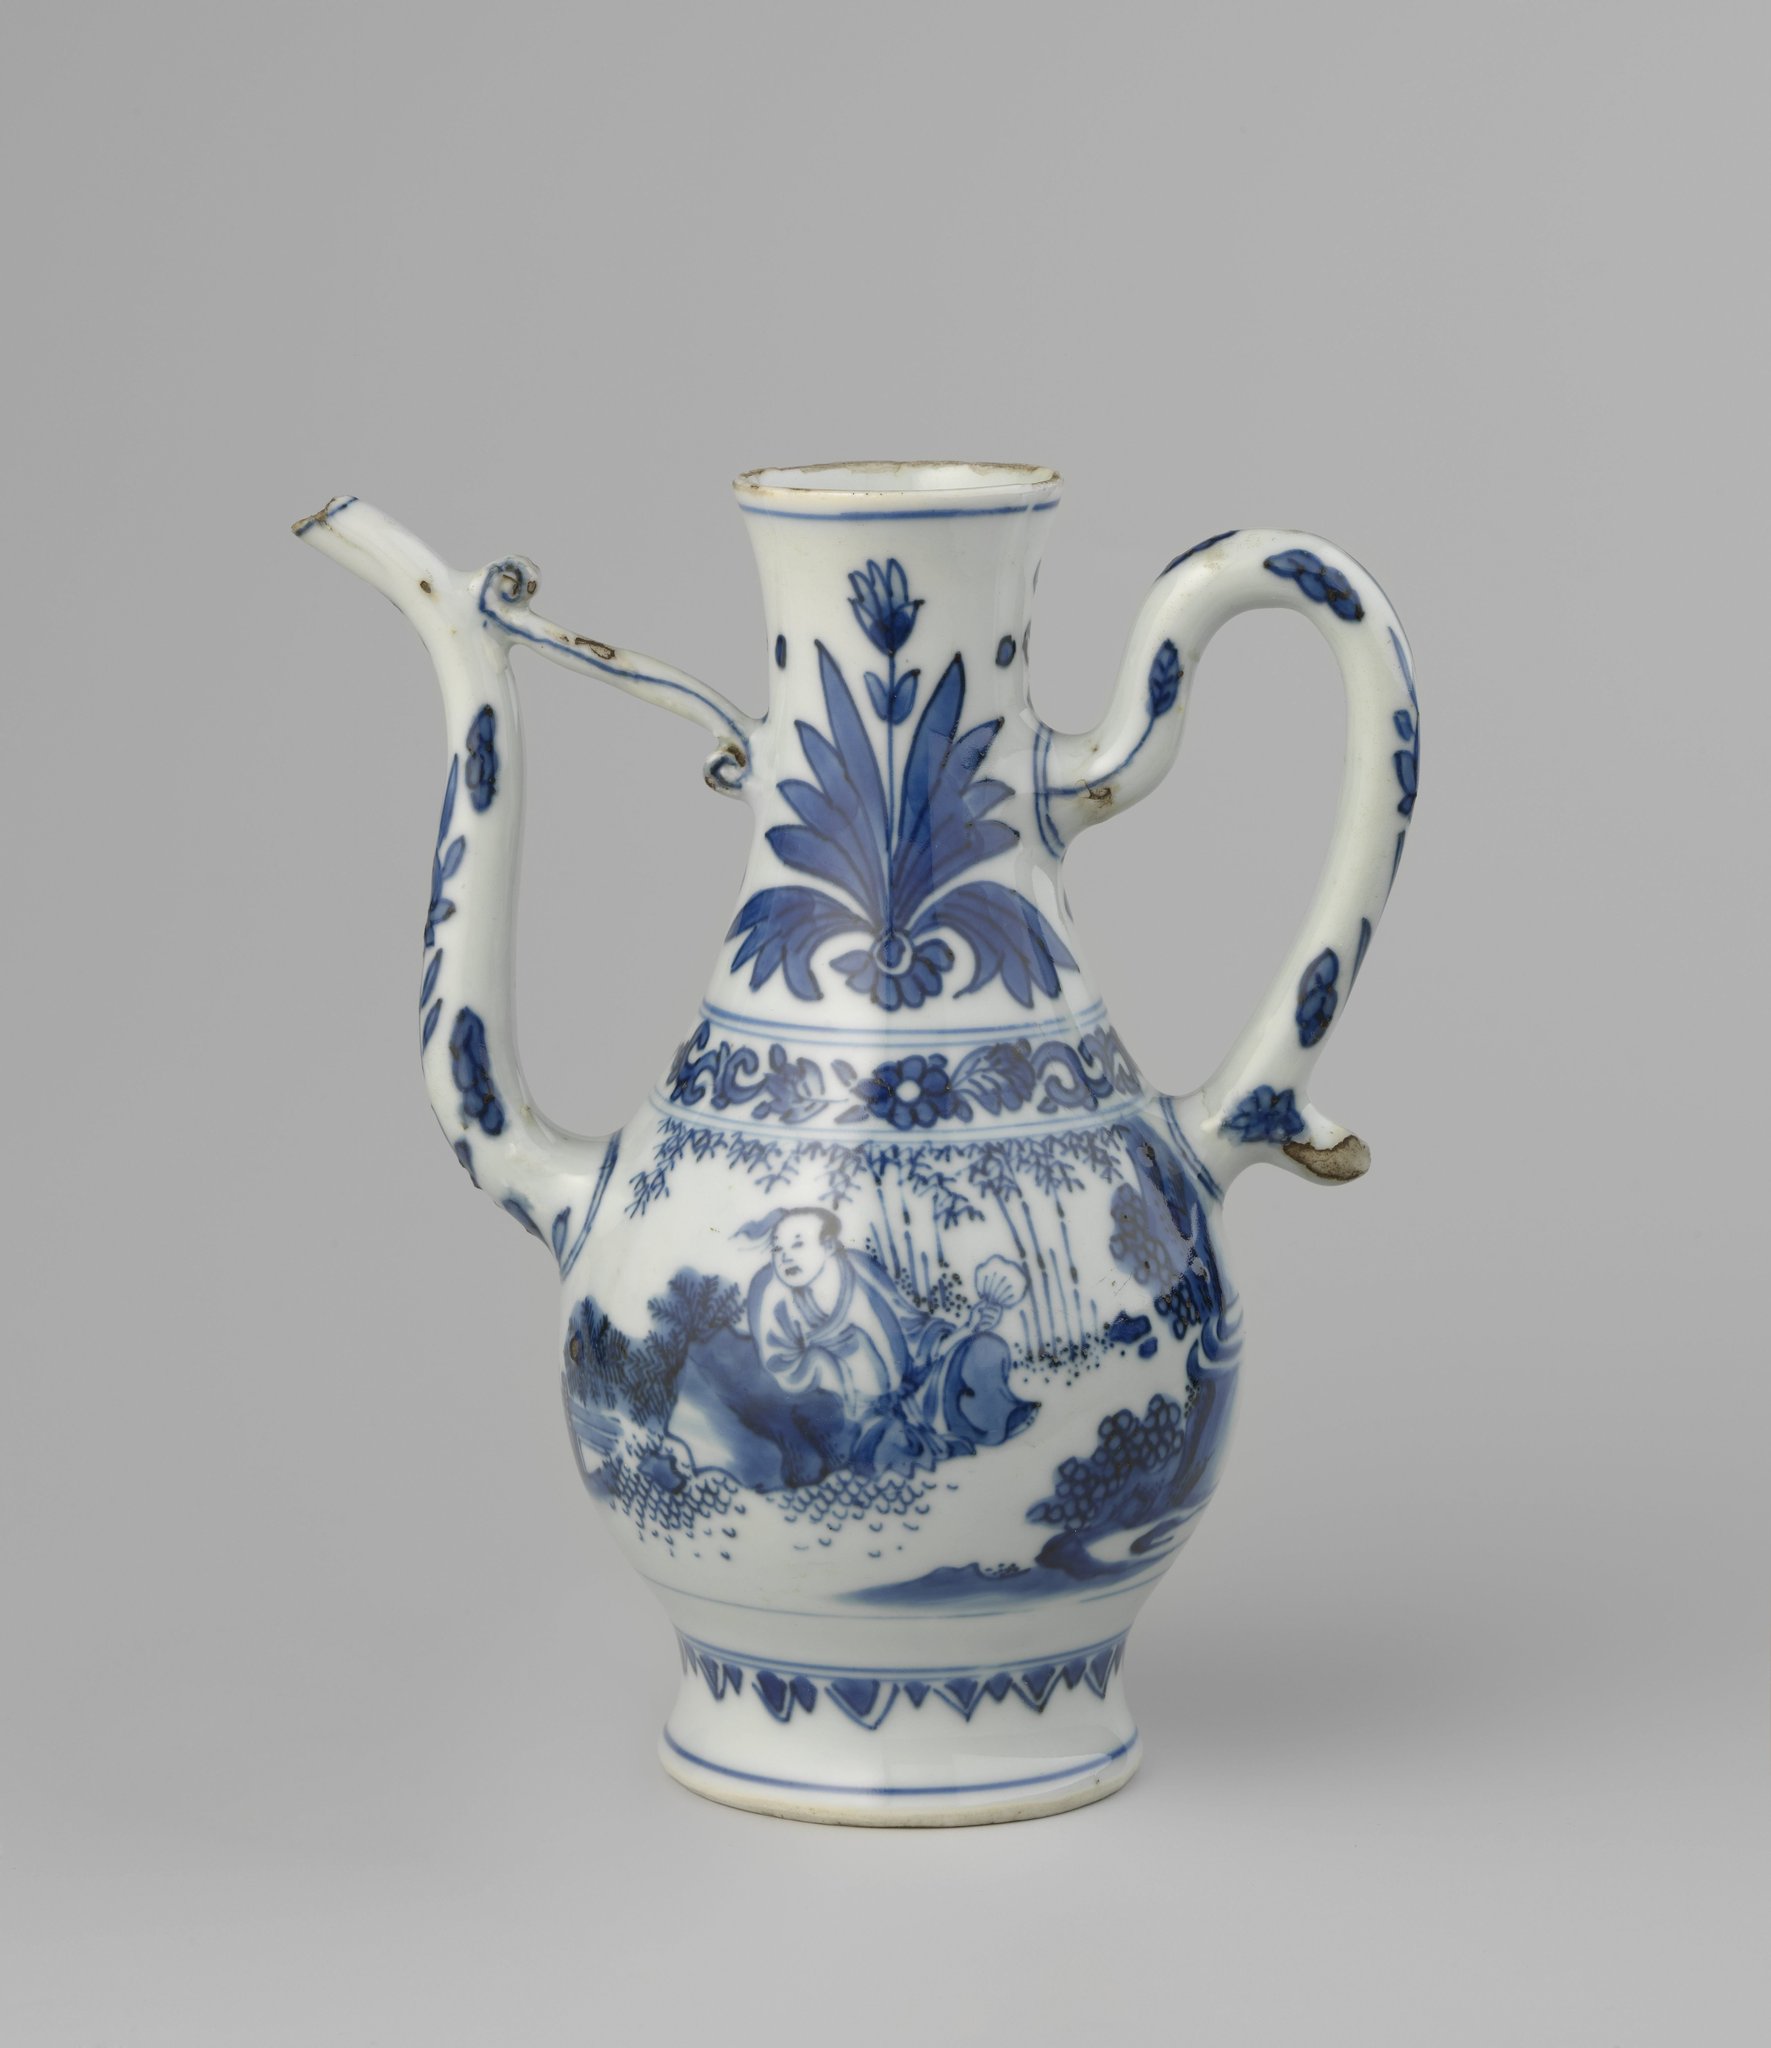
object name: flagon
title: Pear-shaped ewer with a scholar and attendant in a fenced garden, floral scrolls and tulip motif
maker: Anonymous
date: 1635-1650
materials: cobalt, glaze, paint, porcelain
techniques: firing, turning, vitrification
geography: china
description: Schenkkan met oor, tuit en verbindingsstuk. Versiering in onderglazuurblauw met een zittende figuur en een staande in een landschap. Op de hals het tulpenmotief. Chine de Commande.